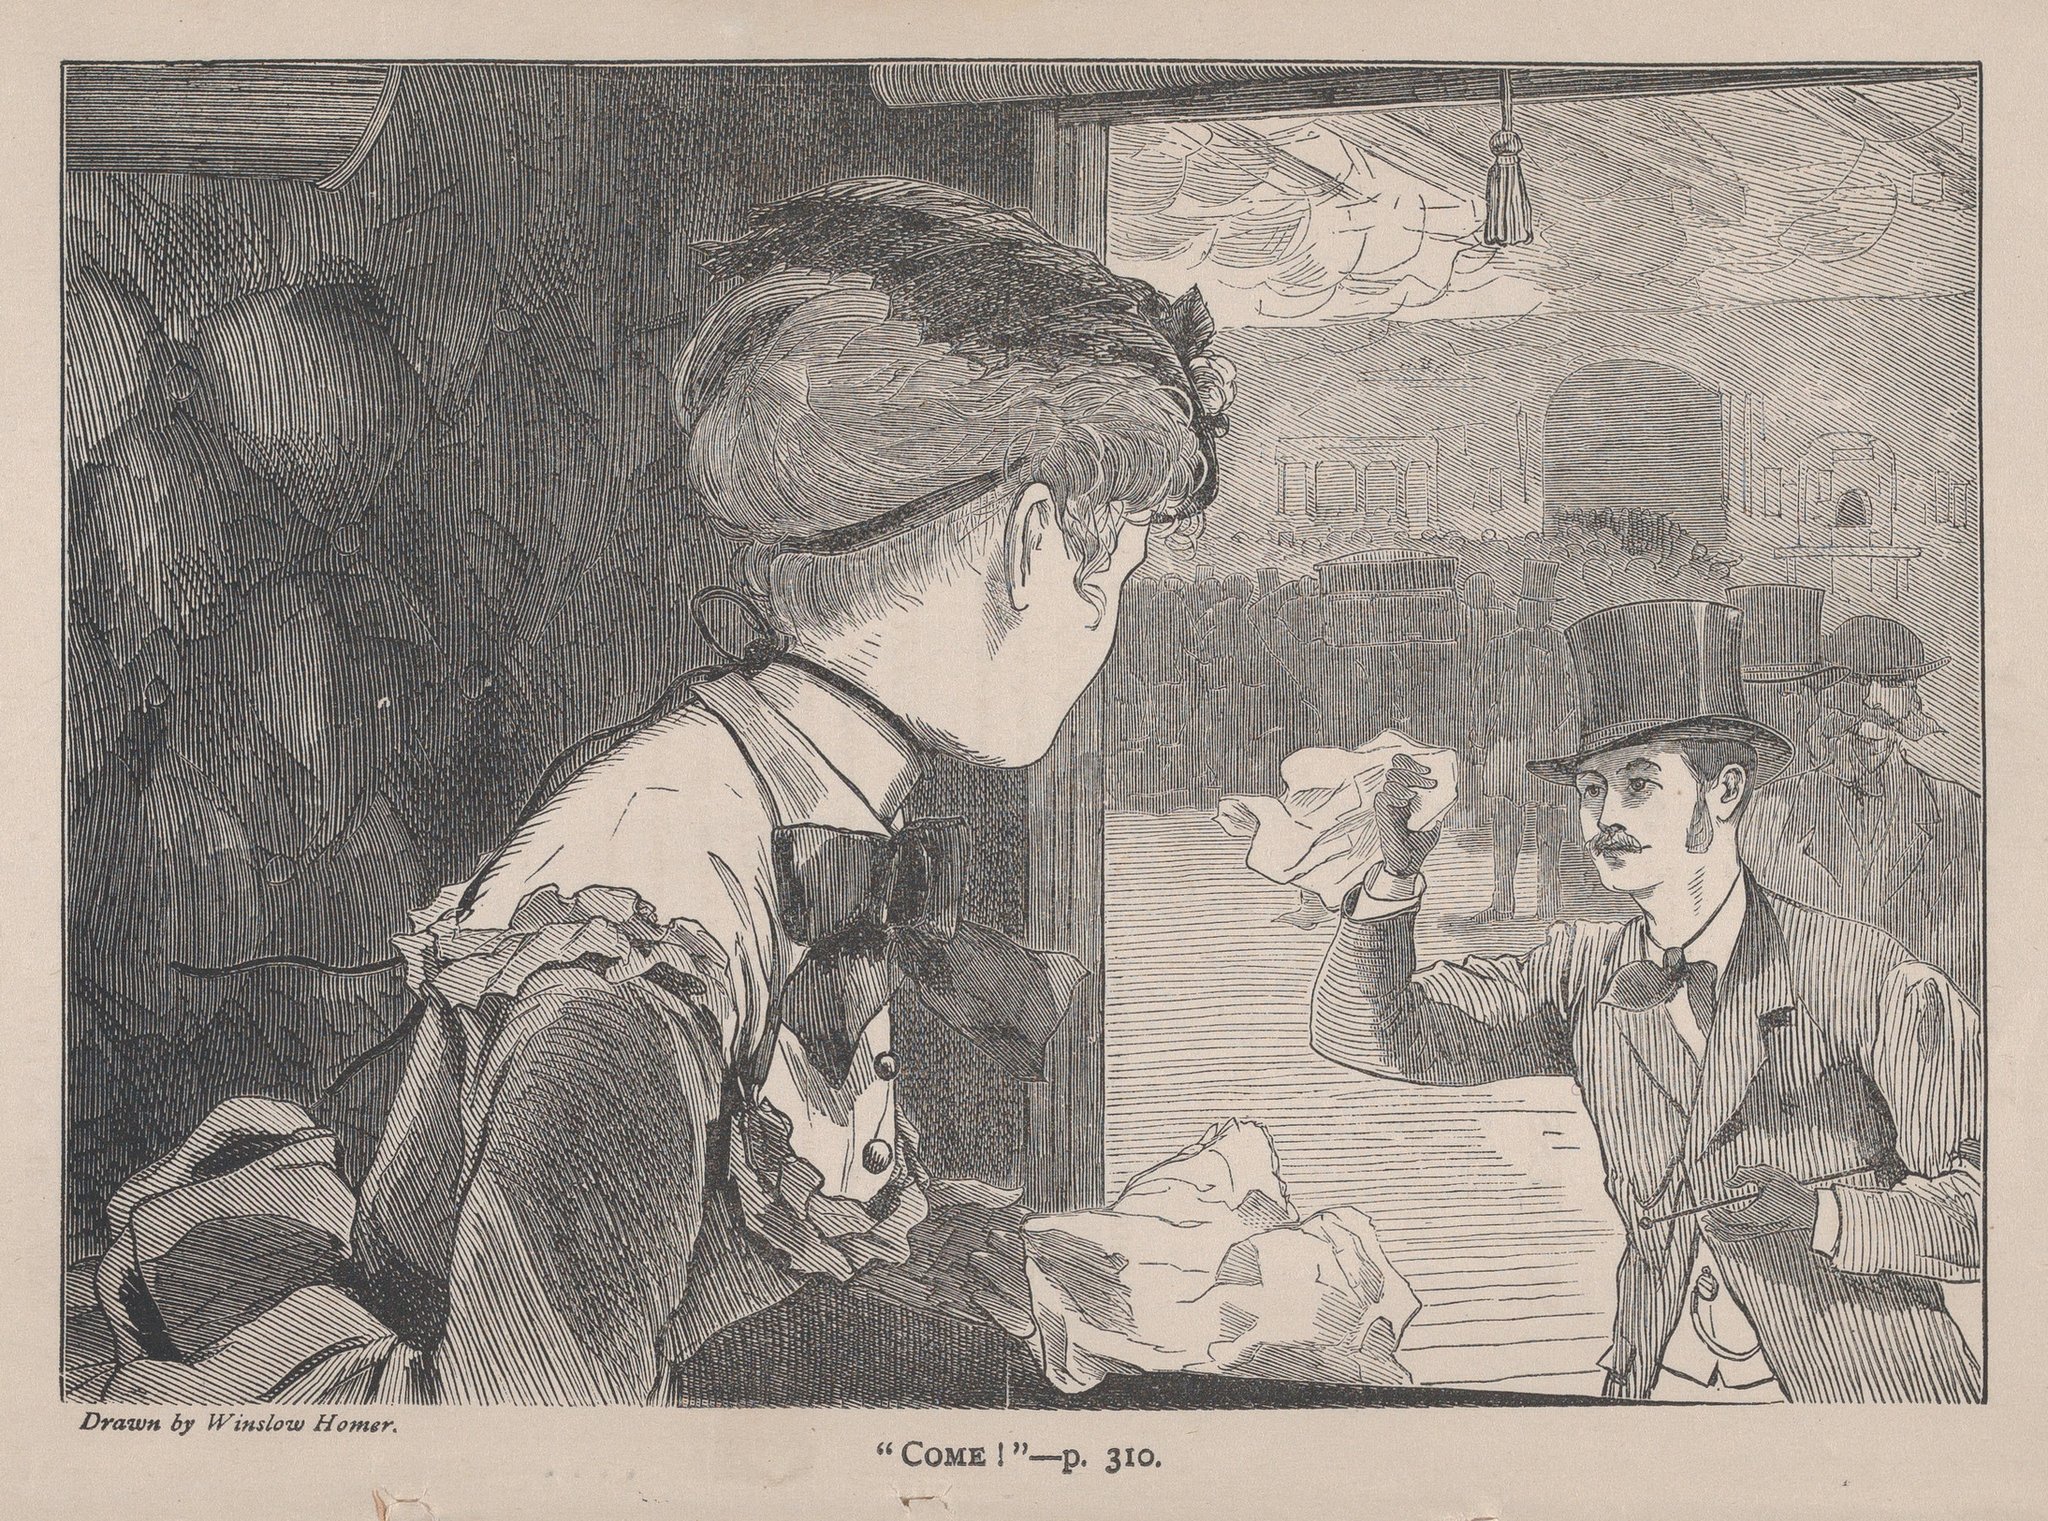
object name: print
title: "Come" (The Galaxy, An Illustrated Magazine of Entertaining Reading, Vol. VIII)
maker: winslow homer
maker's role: artist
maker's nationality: american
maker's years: 1836-1910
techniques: engraving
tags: men,women